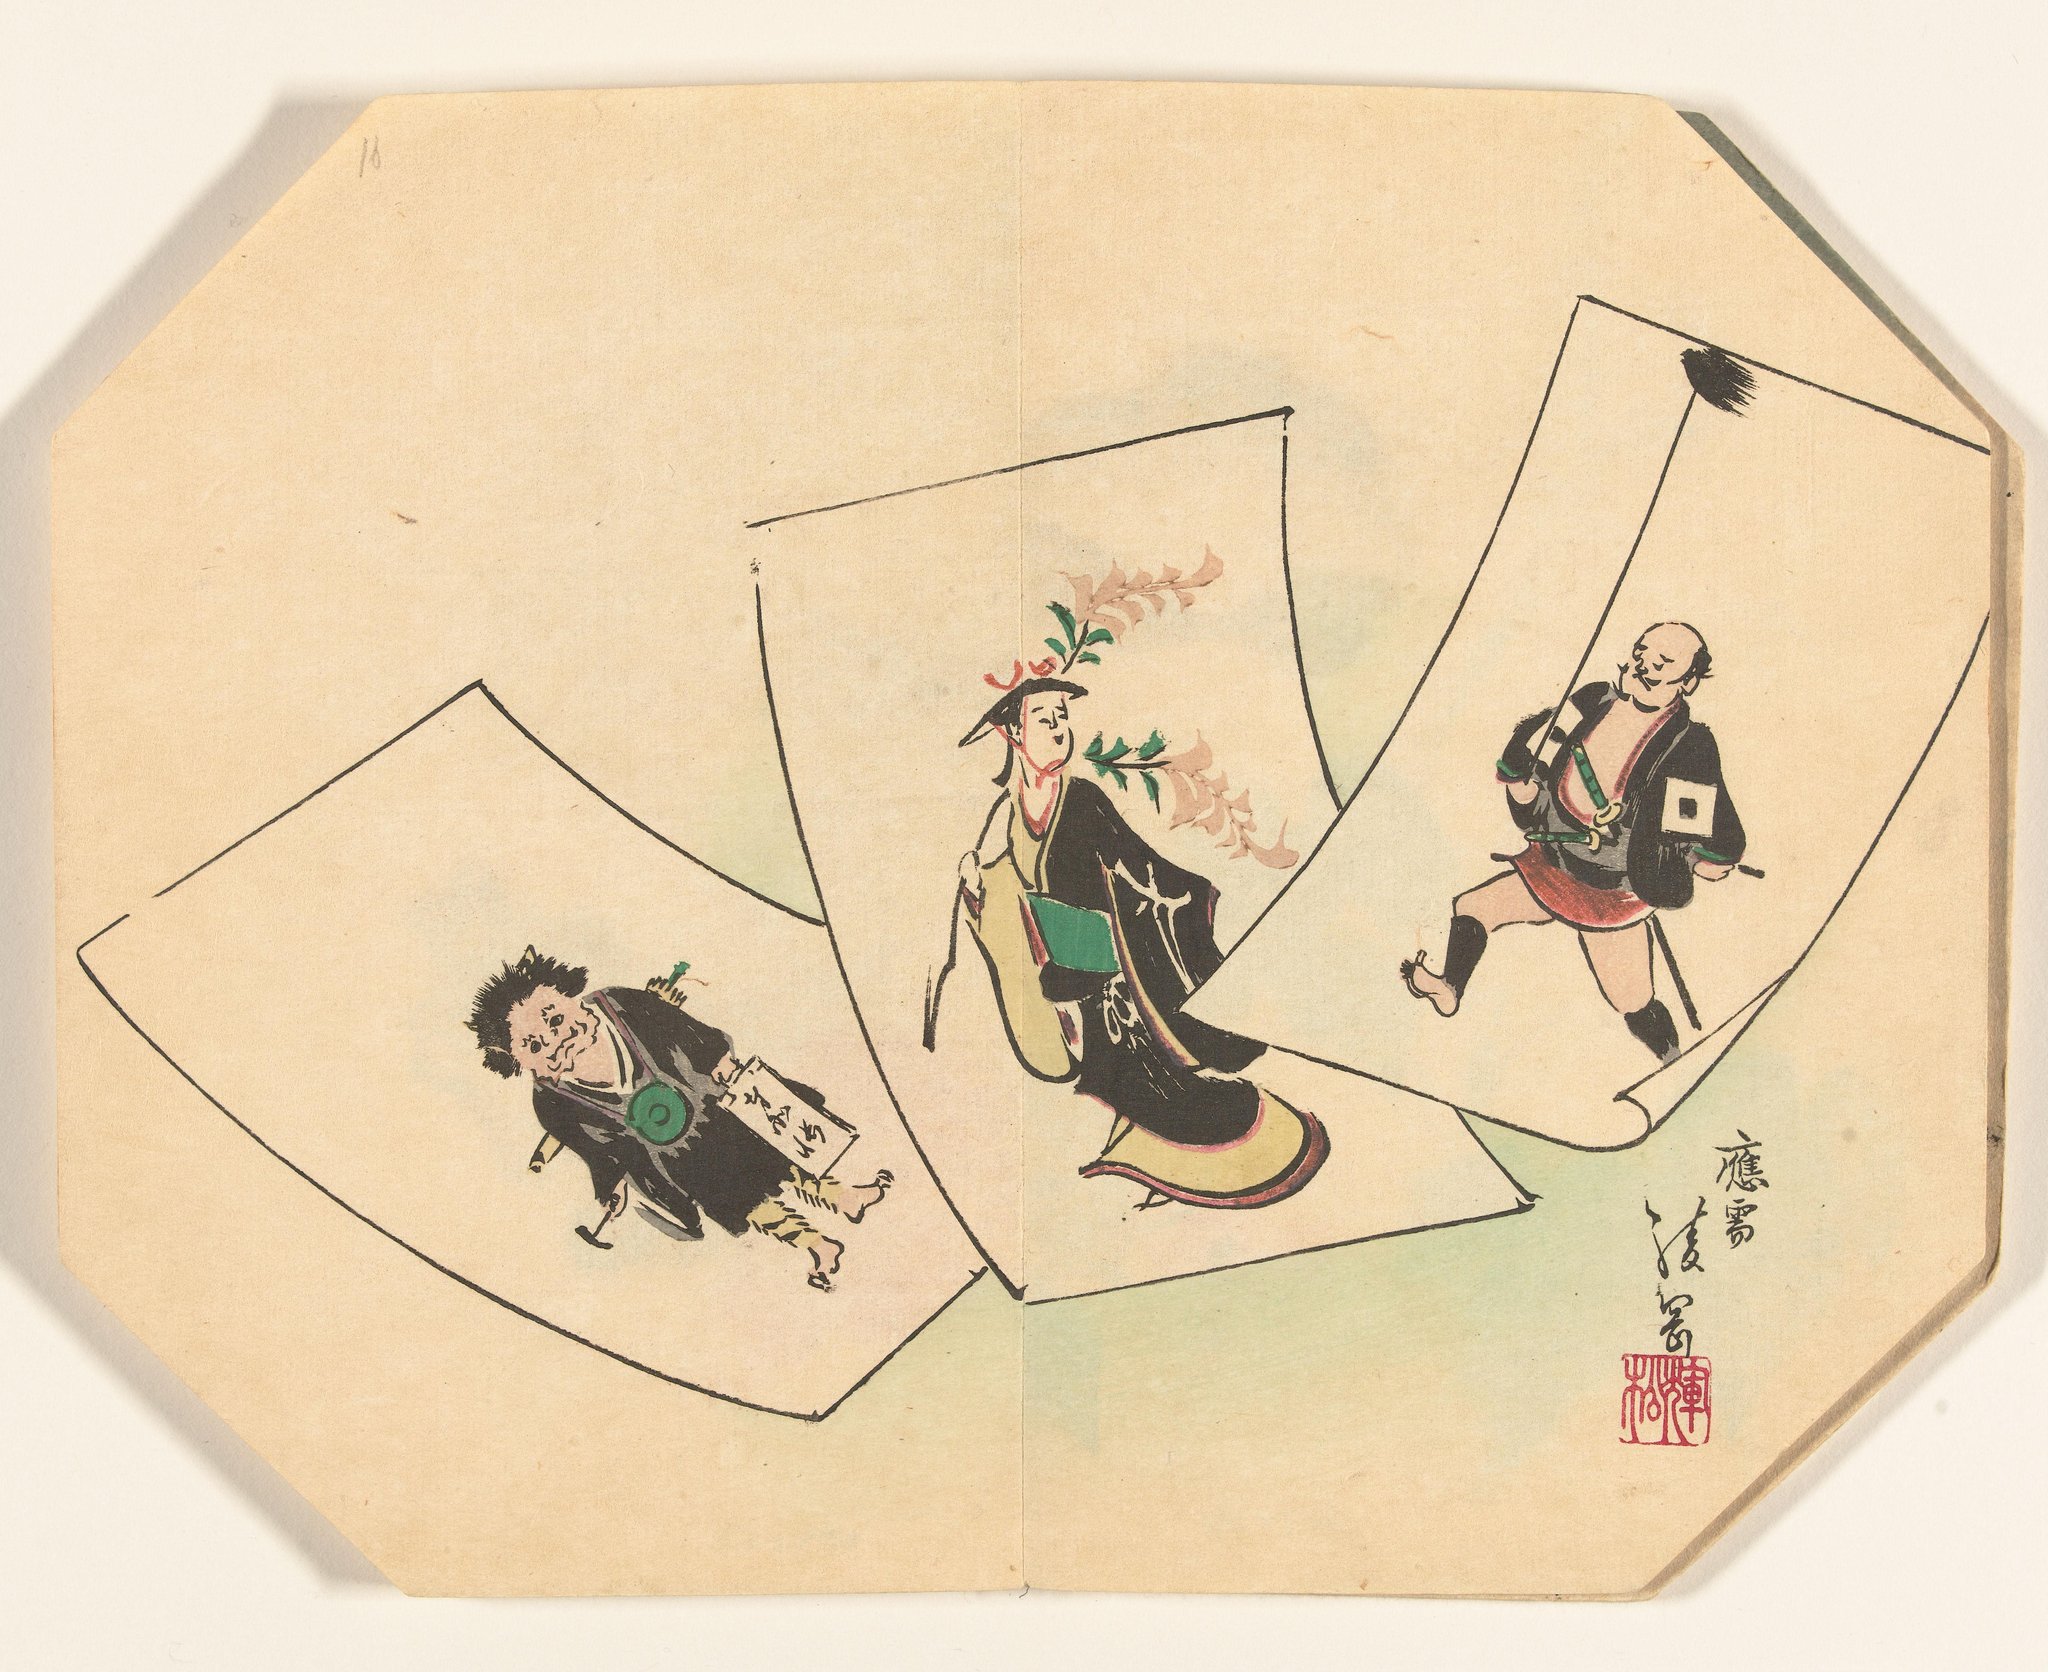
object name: print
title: Drie prenten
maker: ayaoka yûshin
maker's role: print maker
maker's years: 1846-1910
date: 1880-1890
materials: paper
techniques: woodcut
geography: japan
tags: standing figure, print, e.g.: engraving, etching, lithograph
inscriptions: collector's mark: Lugt 2228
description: Octogonale prent in album met 39 prenten.